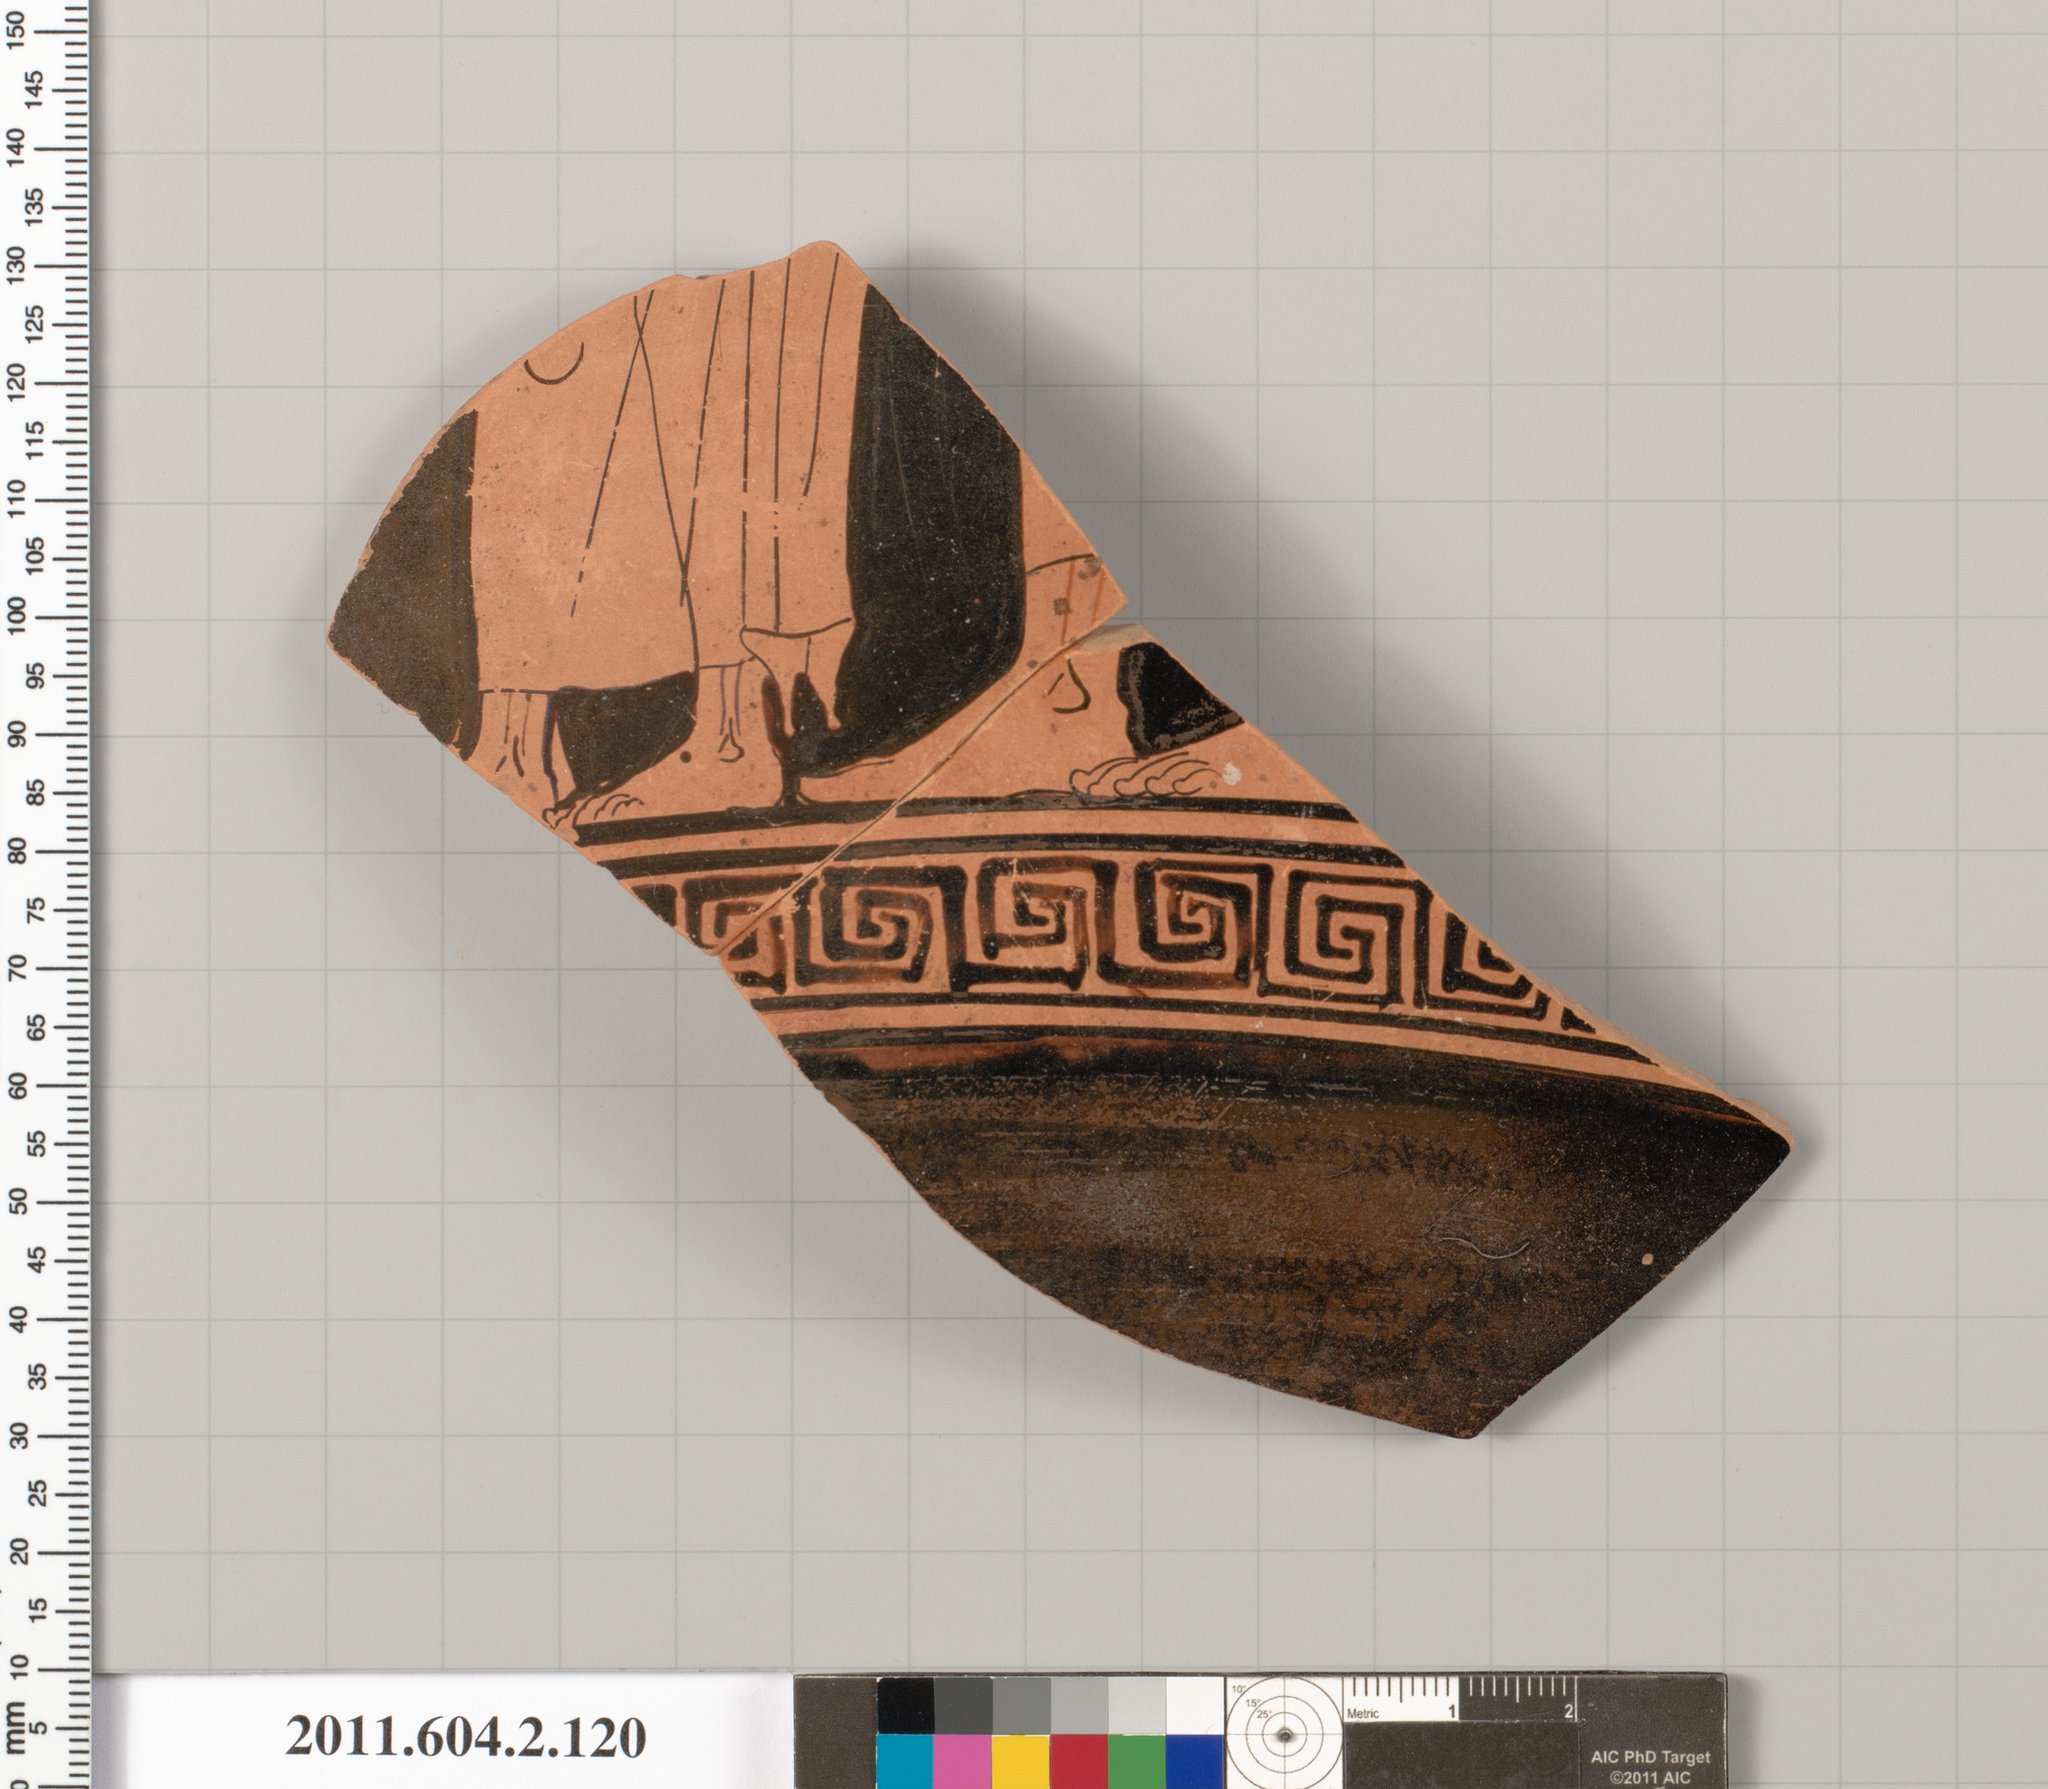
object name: pelike fragment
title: Terracotta fragment of a pelike (jar)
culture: greek, attic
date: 475-451 BCE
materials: terracotta